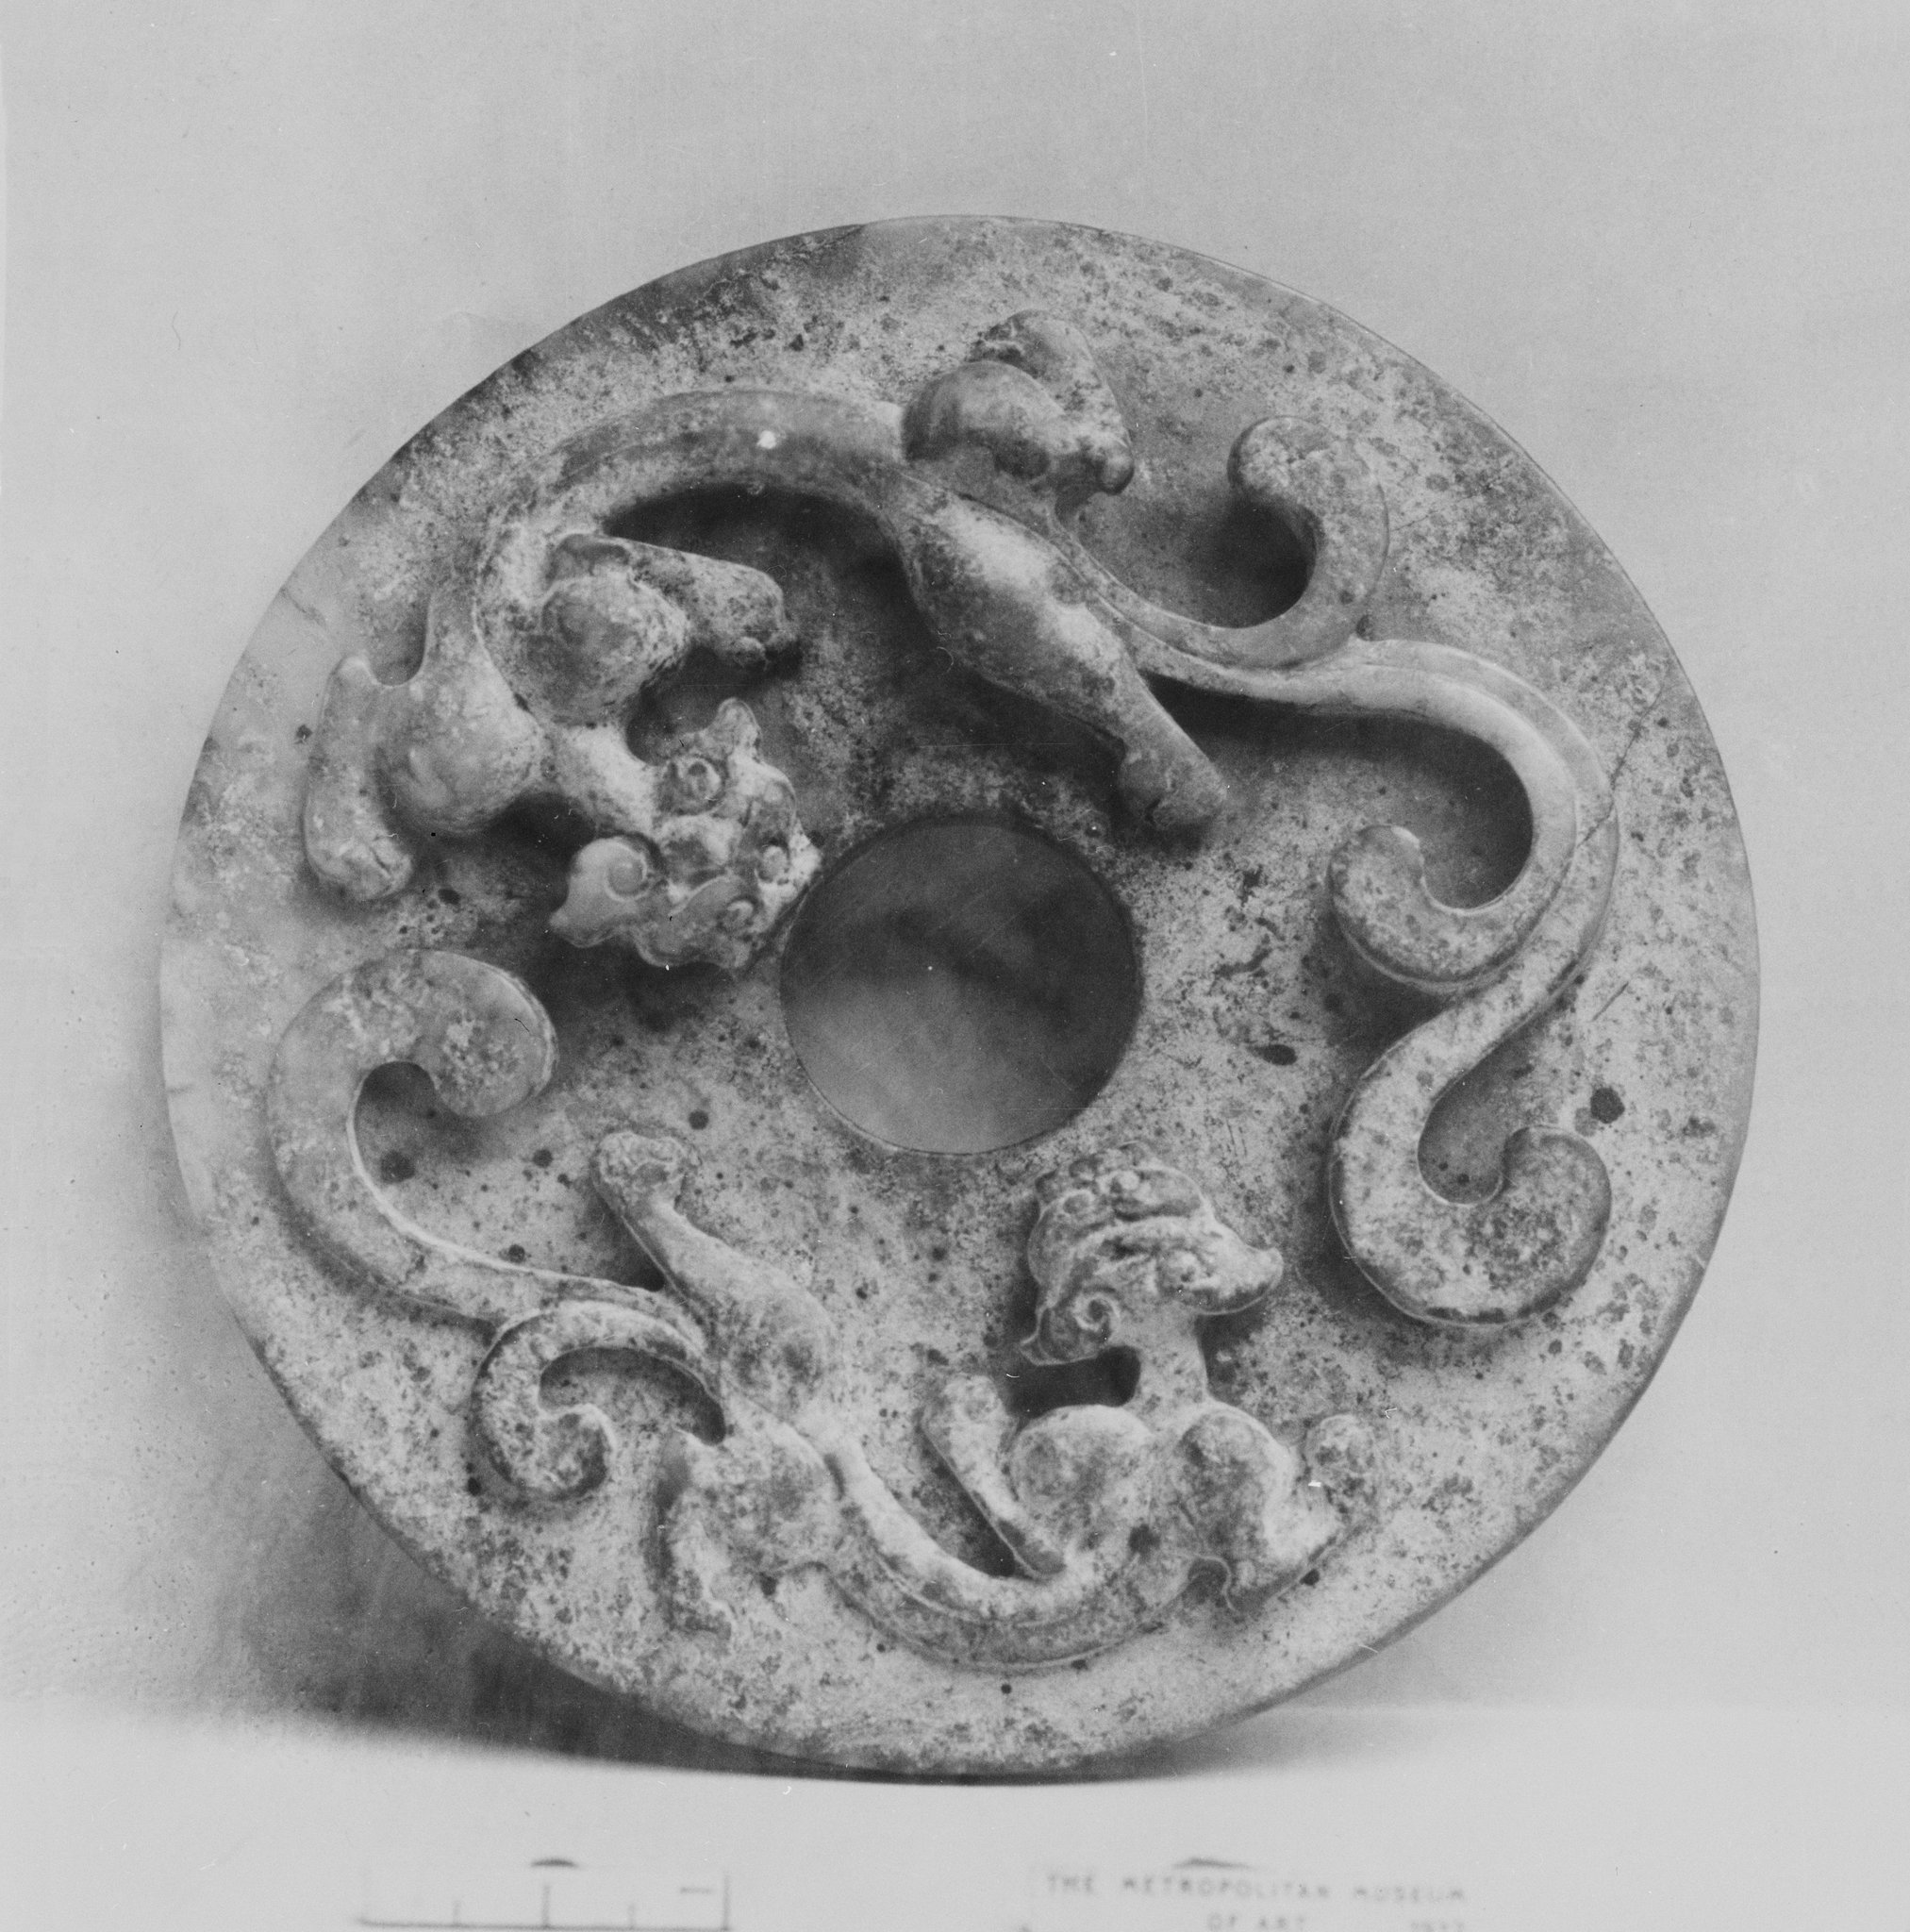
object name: disk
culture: chinese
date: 206 BCE-220 CE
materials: jade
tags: mythical creatures